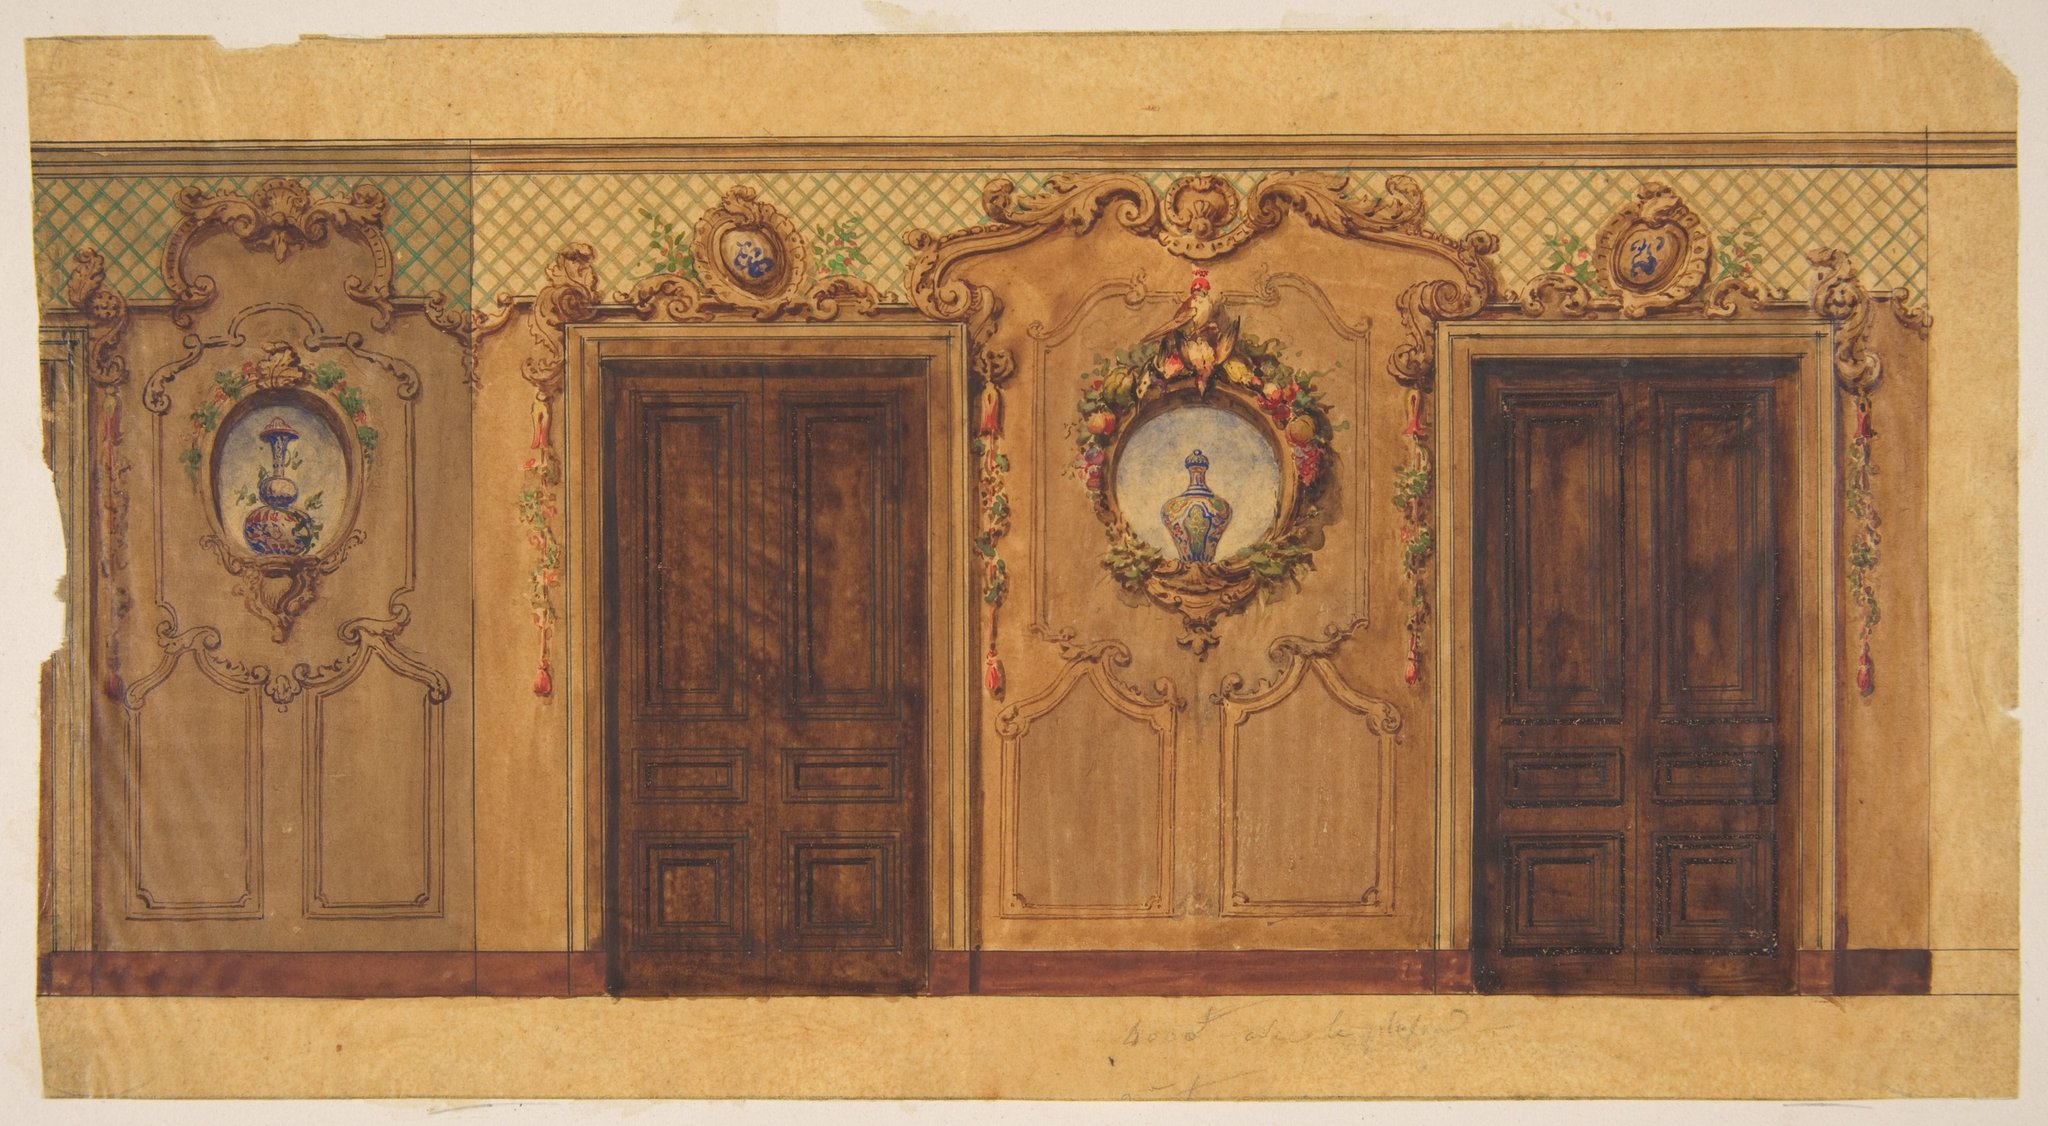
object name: drawing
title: Design for a room with double doors decorated with garlands of fruit and flowers, scrolls, and lattice work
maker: jules-edmond-charles lachaise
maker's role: artist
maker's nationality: french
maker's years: 1897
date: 1830-1897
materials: ink, paper, watercolor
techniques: pen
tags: doors,garlands,fruit,flowers